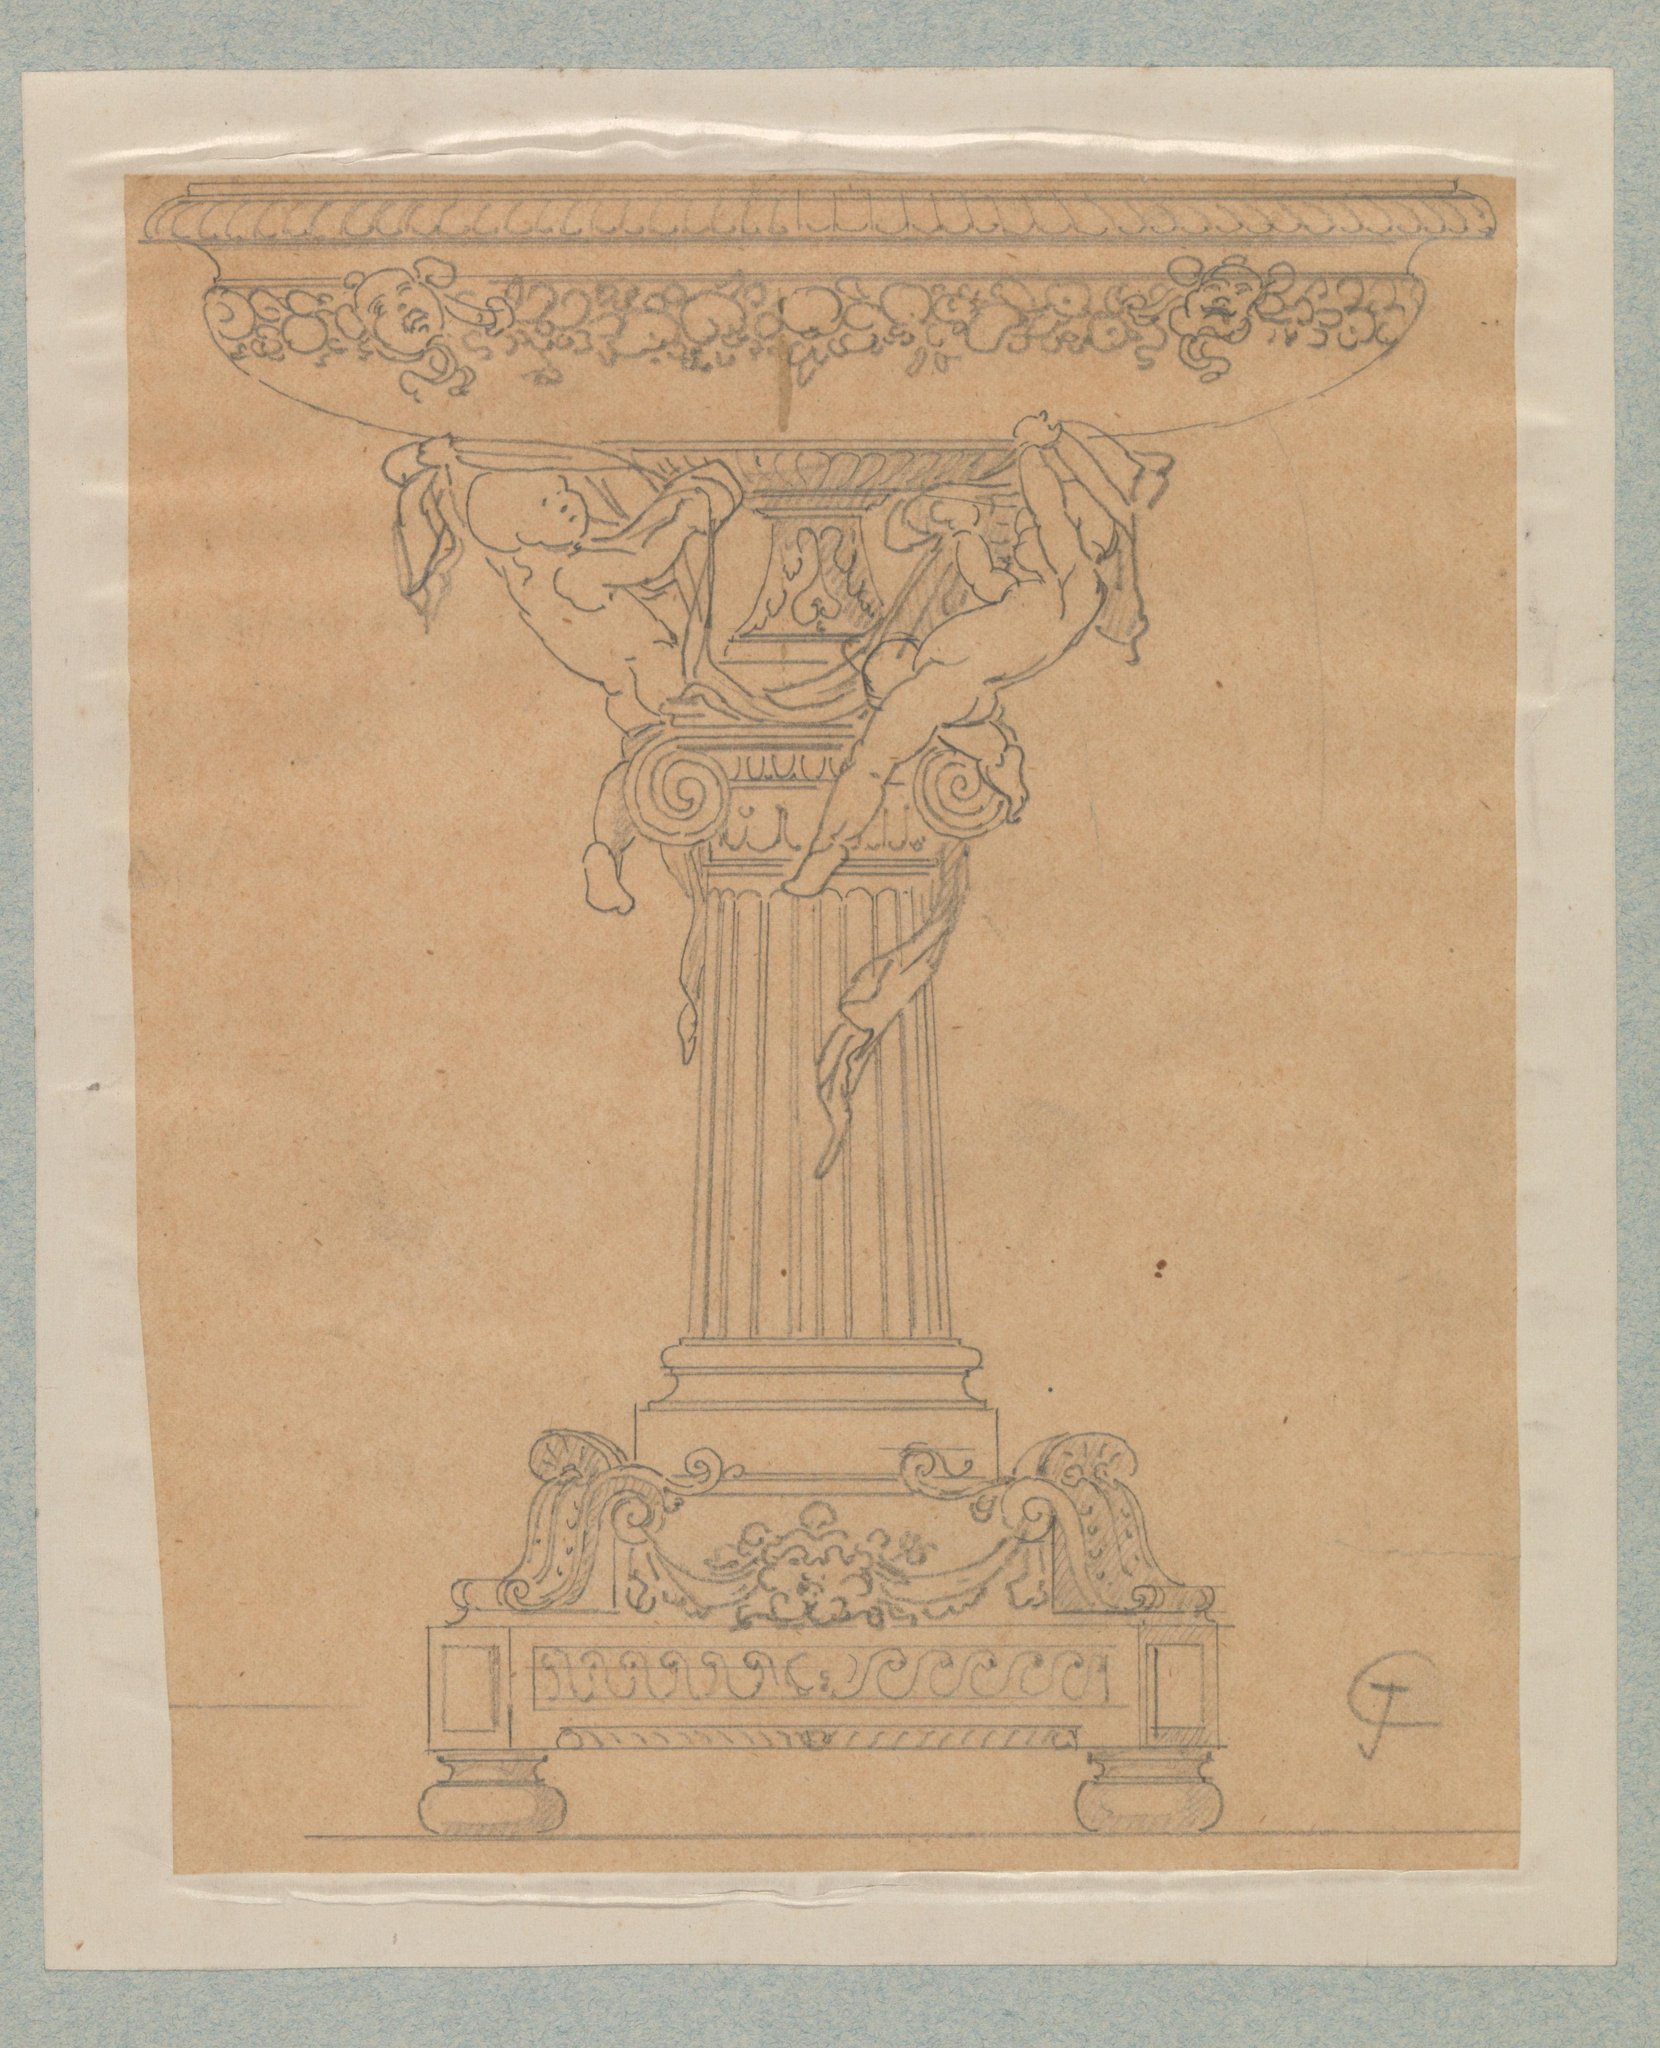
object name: design drawing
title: Bekken met twee jongetjes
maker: gustave joseph chéret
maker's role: sculptor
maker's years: 1838-1894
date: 1870-1894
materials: cardboard, graphite, paper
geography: paris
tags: containers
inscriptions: label: ‘942’, label: ‘Exposition / Œuvres Joseph Chéret / Décembre 1894’, workshop stamp: ‘Joseph Chéret’, monogram: ‘JC’, inscription: ‘Vasque’